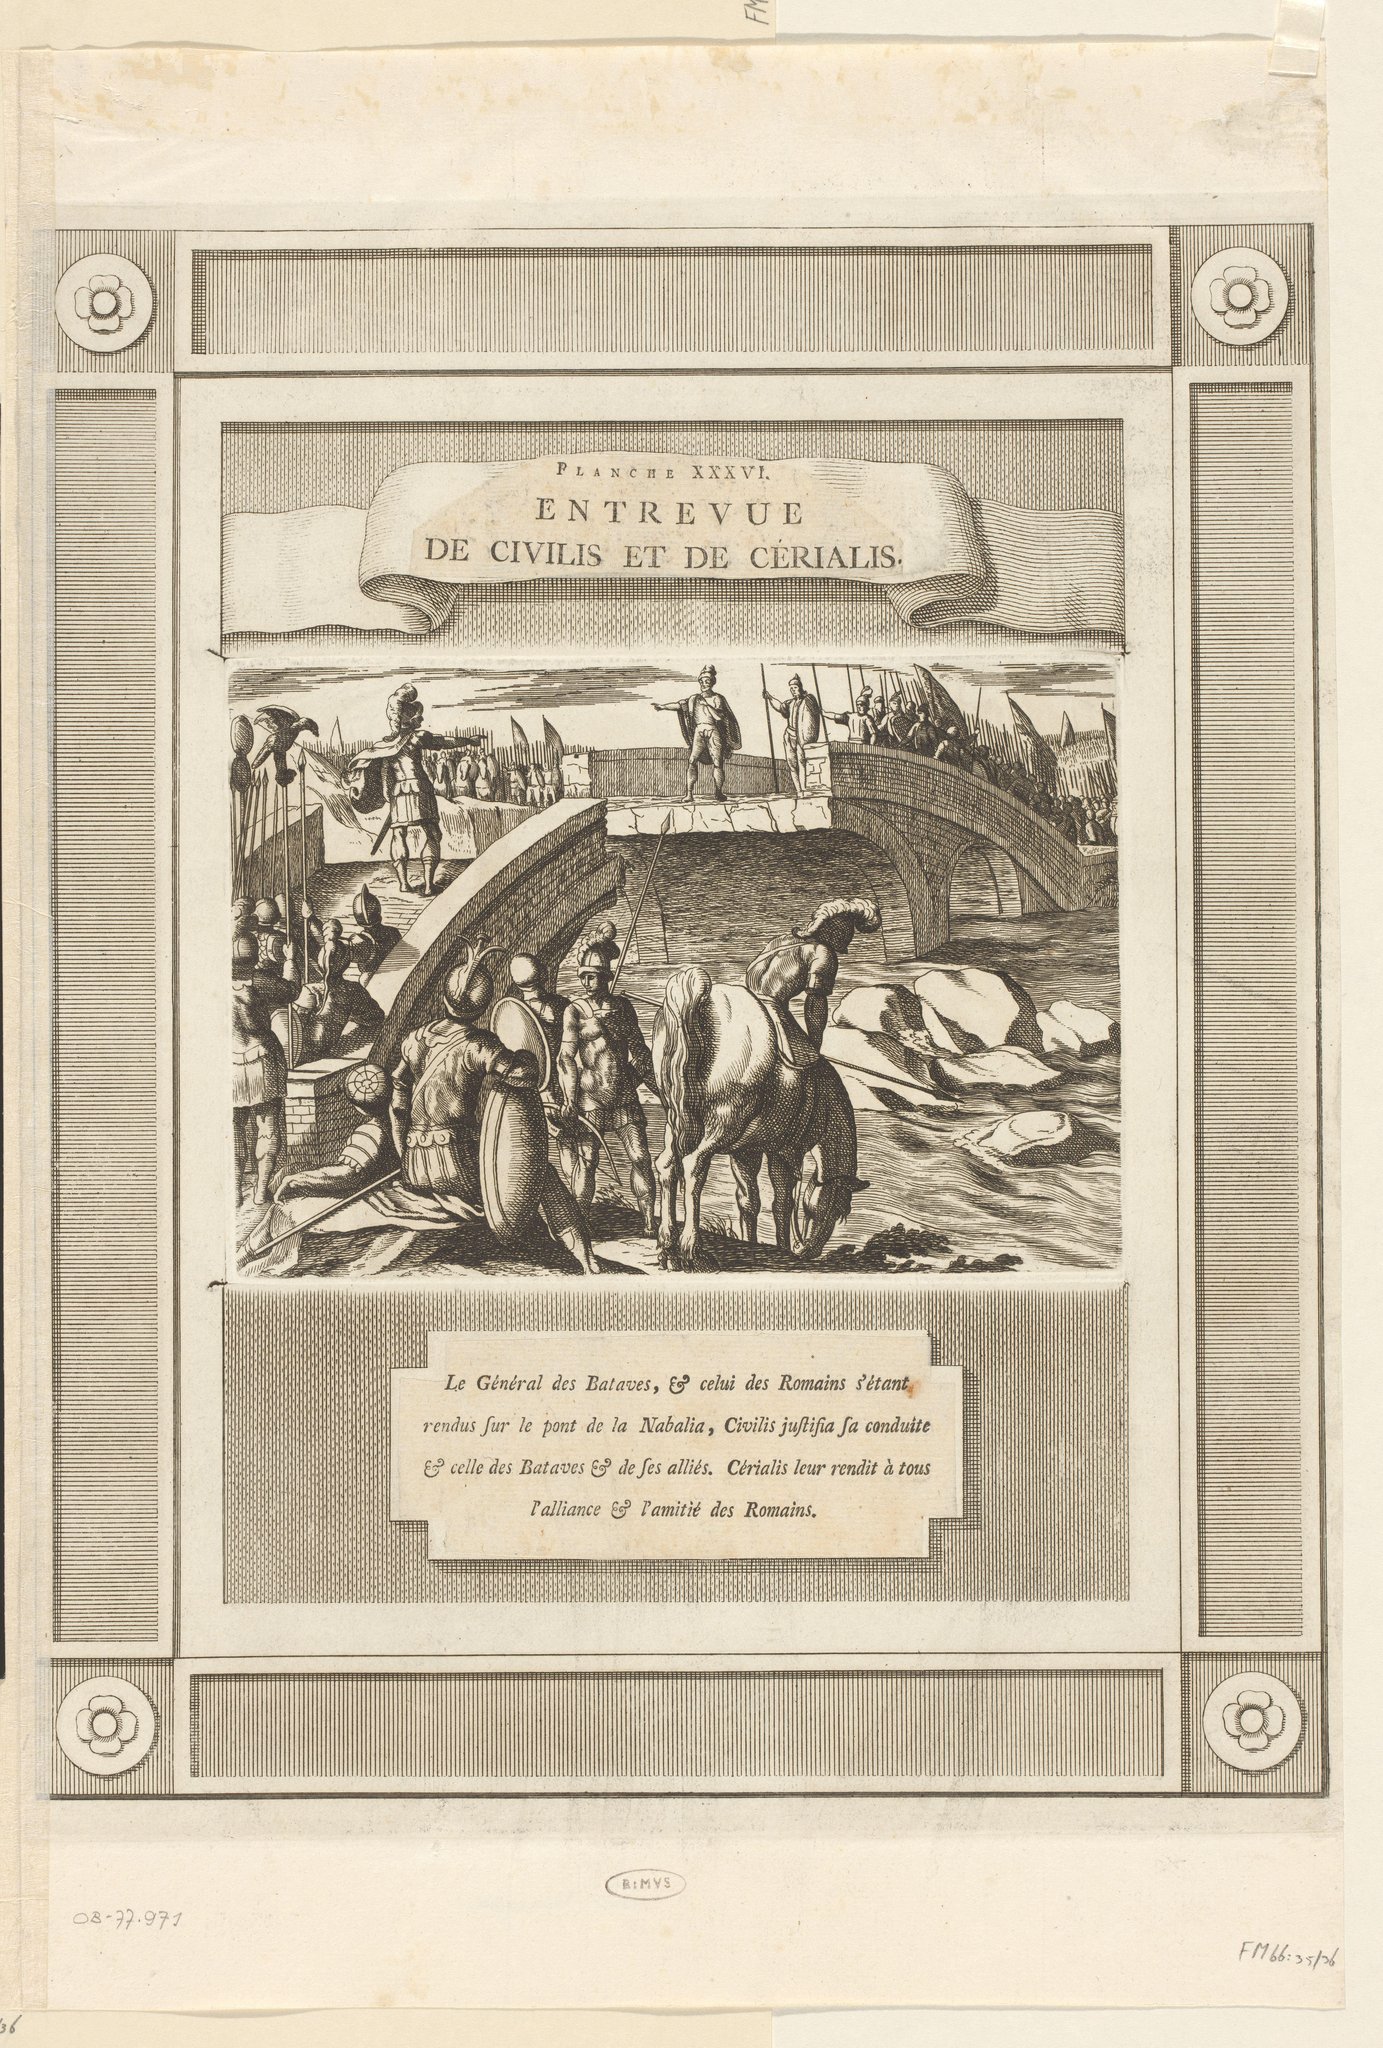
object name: history print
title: Kopieën naar Tempesta's Bataafse Opstand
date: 1768-1770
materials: paper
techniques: engraving, etching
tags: peace negotiations, extinct, 'historical' peoples (with name), netherlands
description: Civilis en Cerialis onderhandelen en sluiten vrede op de afgebroken brug. Prent 36 in een serie over de Bataafse Opstand, gekopieerd naar de reeks Batavorum cum Romanis bellum van Antonio Tempesta (Otto Vaenius, Antwerpen 1612). Illustratie voor: Marquis de St. Simon, Histoire de la guerre des Bataves et des Romains, d'après César; Corneille Tacite, Aux dépens de Marc-Michel Rey, Amsterdam 1770. Voorstellingen gedrukt in een grote ornamentele omlijsting waarin bovenaan een uitgeknipte titel en onderaan een onderschrift in het Frans is geplakt. Gedrukt op de achterzijde van planche XXXV.